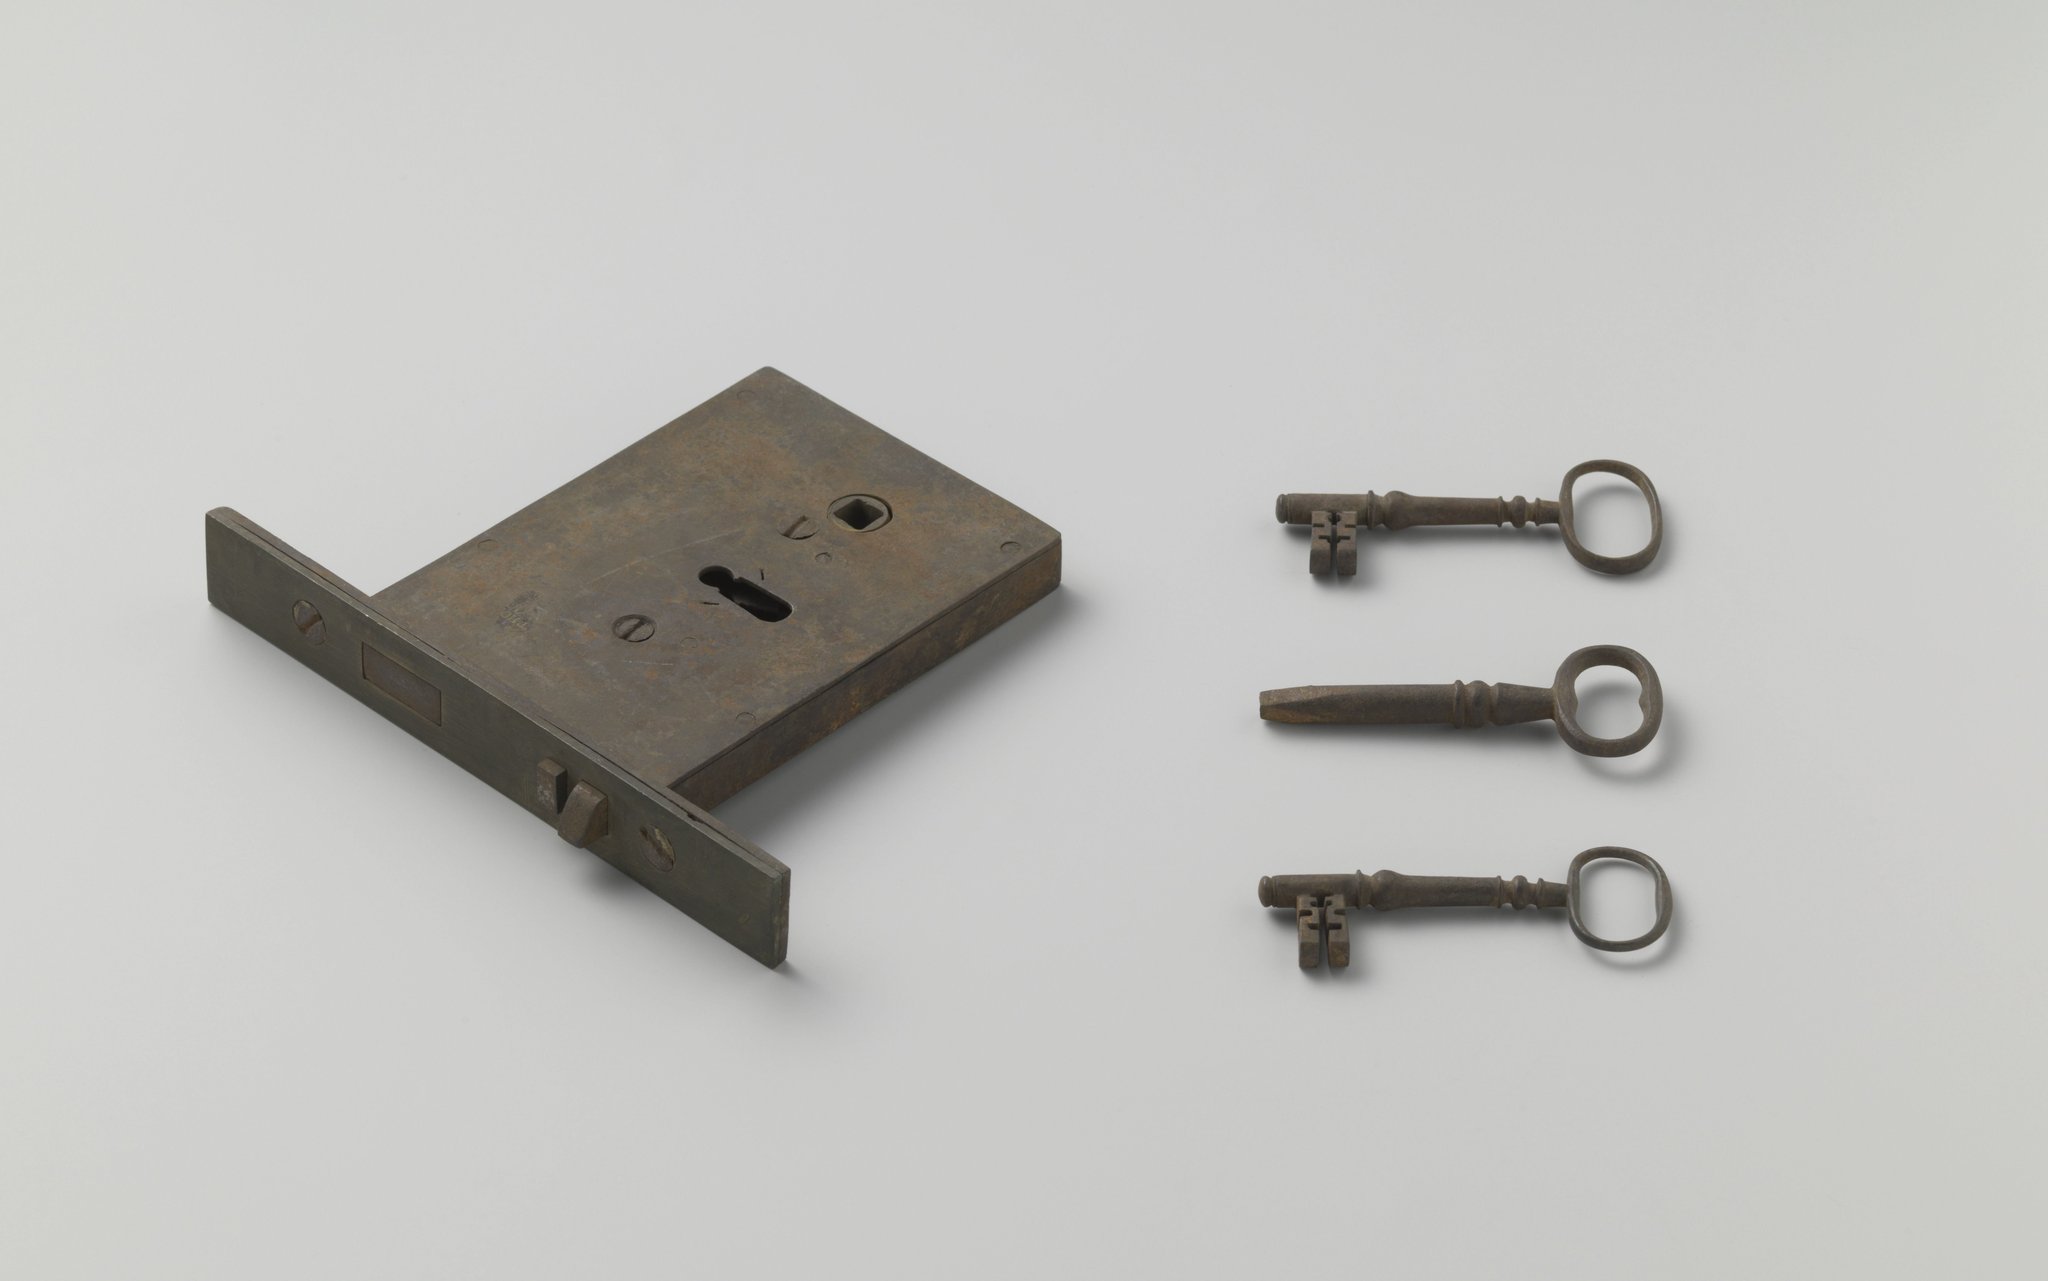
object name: key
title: Deurslot met drie losse sleutels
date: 1700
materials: iron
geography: netherlands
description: Een ijzeren deurslot met drie daarbij behorende sleutels. Het onversierde slot heeft één sleutelgat en een vierkante opening, welke in een cirkelvormige koperen plaat is aangebracht voor de baardeloze sleutel. Een koperen plaat is door middel van twee schroeven bevestigd aan de slotplaat. Het slot is gemerkt. Twee sleutels hebben geprofileerde, eenigzins balustervormige stelen; de baard bestaat uit twee getande symmetrische stukken, het sleuteloog is ovaalvormig en onversierd.